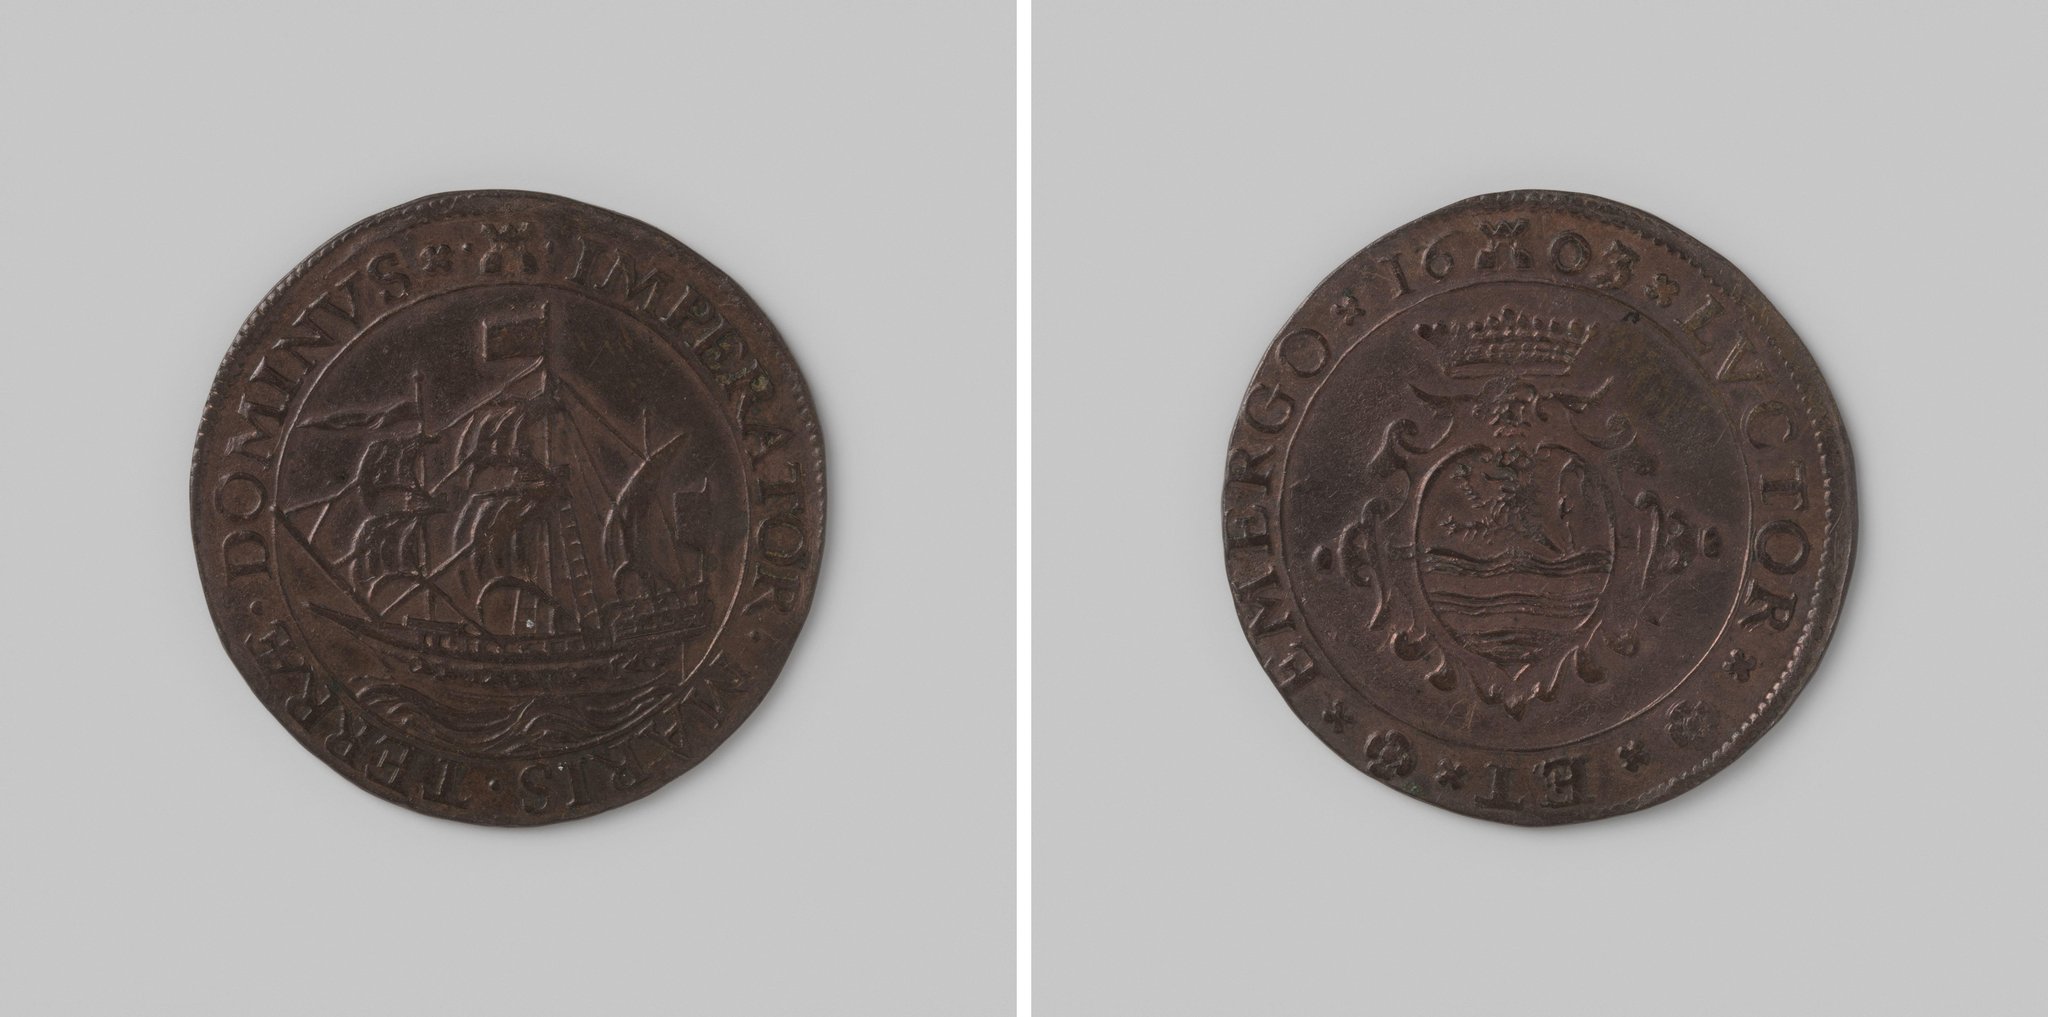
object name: jeton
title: Rekenpenning uit Middelburg ter aanmoediging van de zeevaart op Indië (?) 1603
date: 1603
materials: copper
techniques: striking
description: Koperen penning, op de voorzijde een zeilschip naar links met omschrift, op de keerzijde het gekroonde wapenschild van Zeeland in een cartouche, met omschrift.